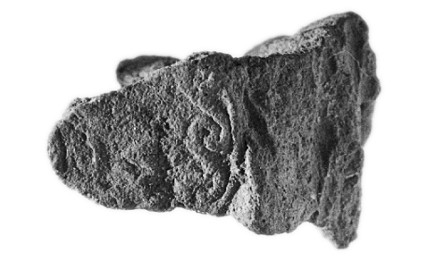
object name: sealing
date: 1981-1640 BCE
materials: mud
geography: egypt